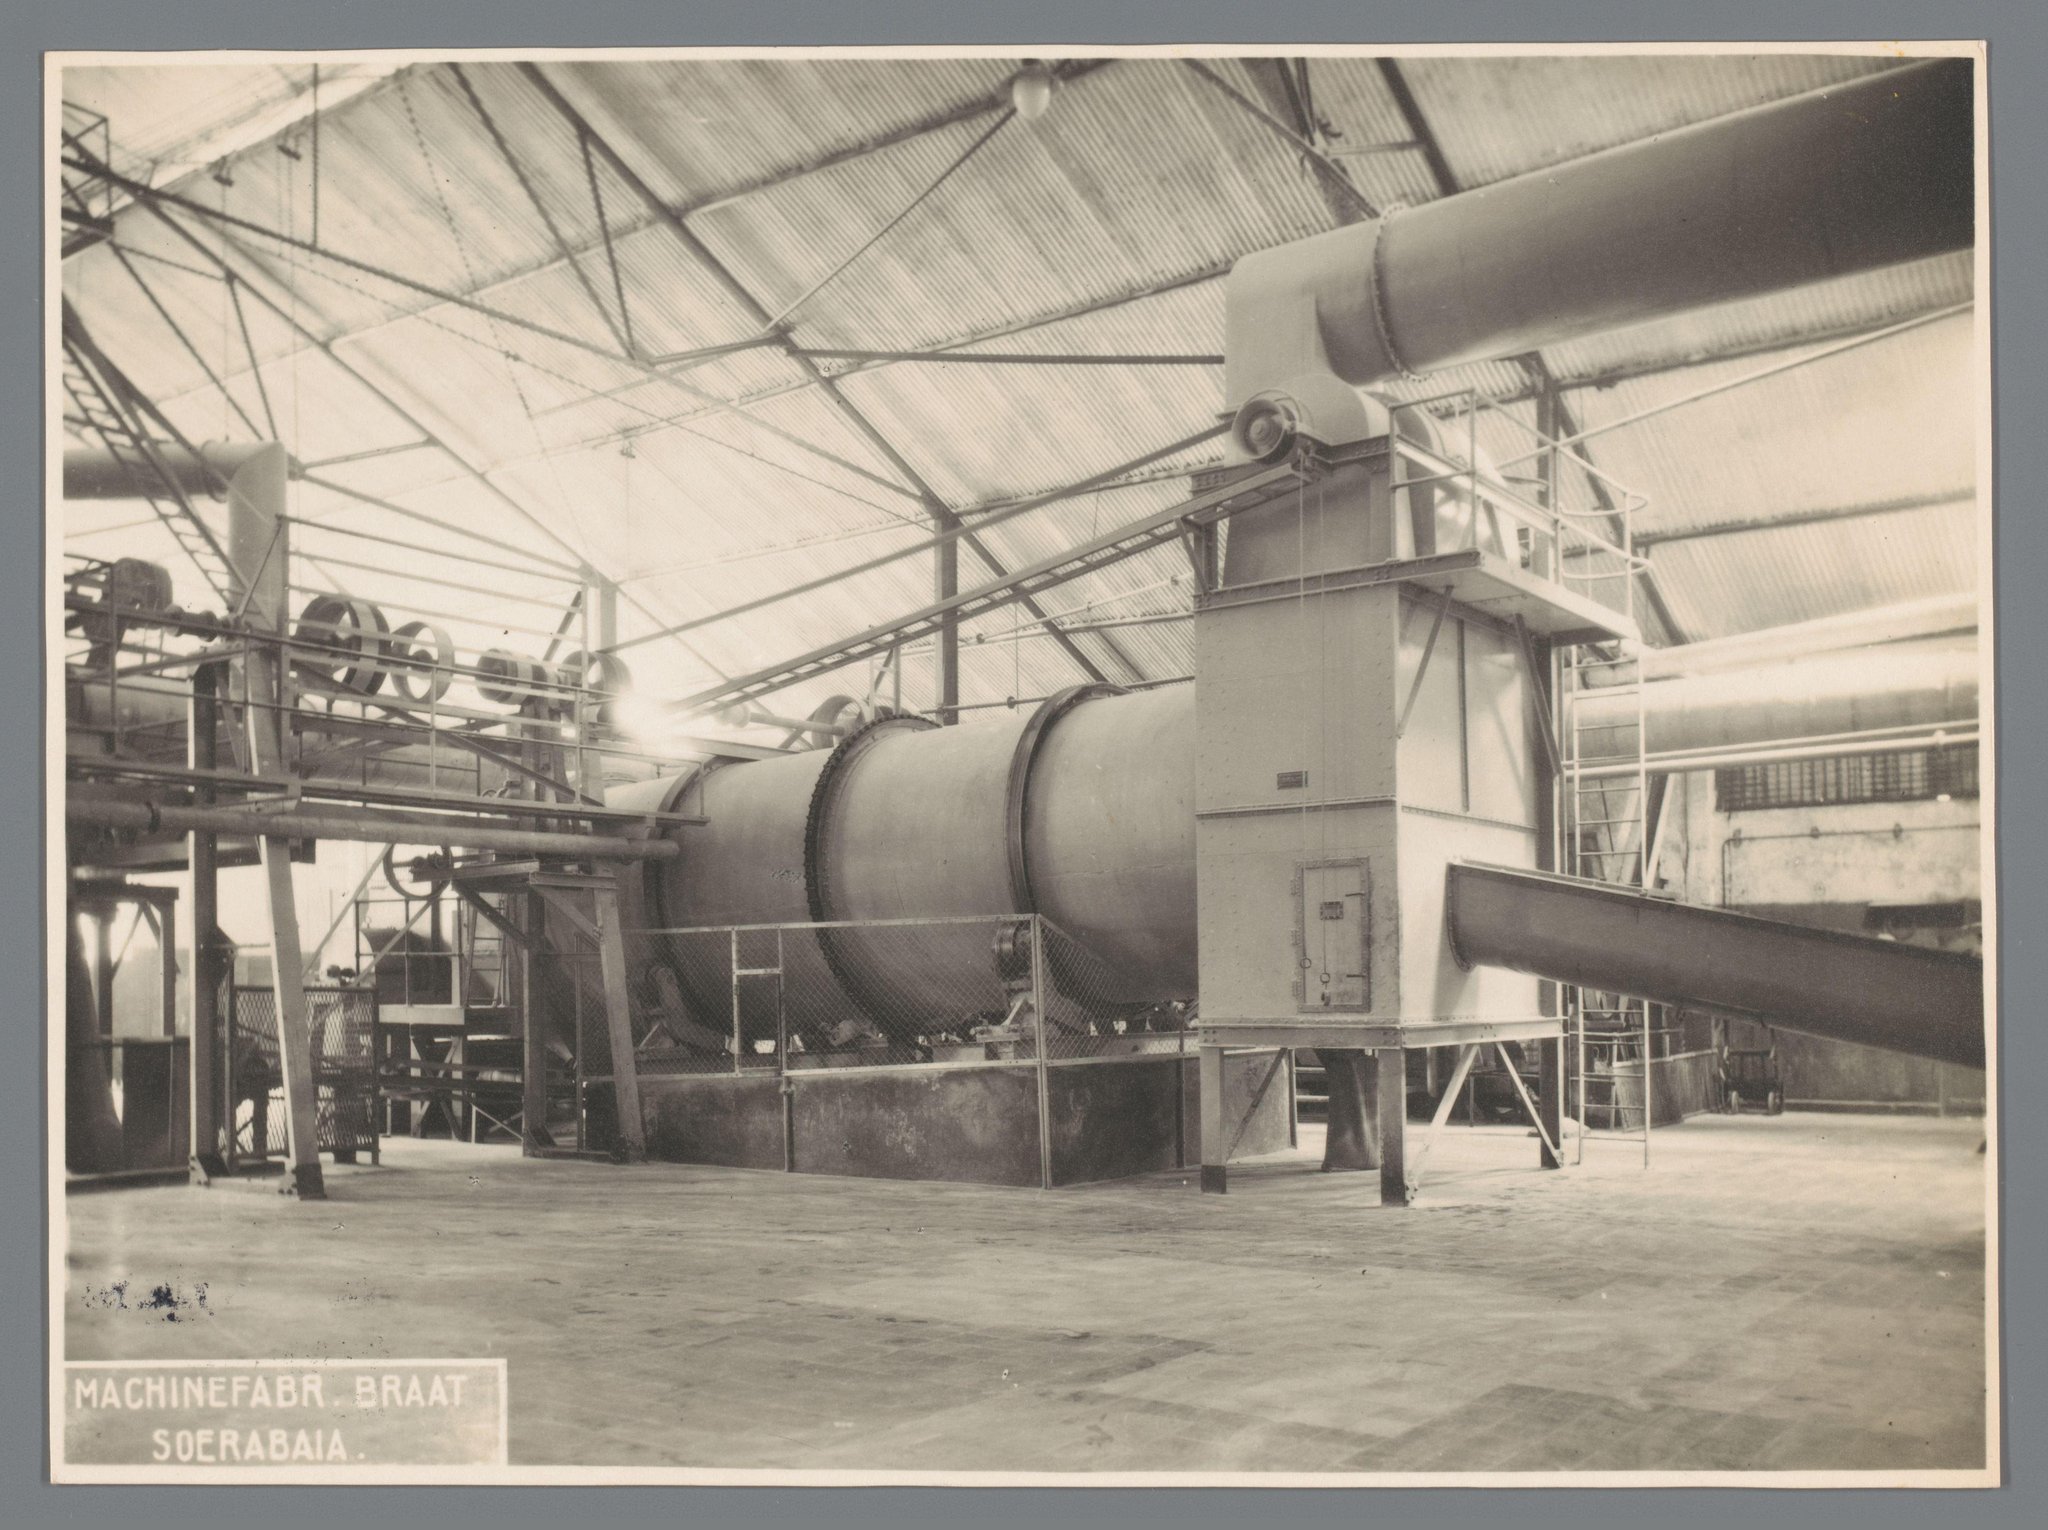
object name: photograph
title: Suikerdrooginstallatie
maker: Anonymous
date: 1908-1937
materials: photographic support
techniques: gelatin silver print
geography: surabaya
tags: colonial system, factory-interior, machine shop, machines; parts of machines; tools and appliances, (non-fruit) products of plants or trees: sugarcane, java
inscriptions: date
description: Suikerdroger vervaardigd in 1937 voor de Suikerfabriek Gempolkrep. Onderdeel van de multomap met foto's van machines van de N.V. Machinefabriek Braat te Soerabaja bestemd voor de Nederlandse suikerindustrie op Java, uit de periode 1917-1938.